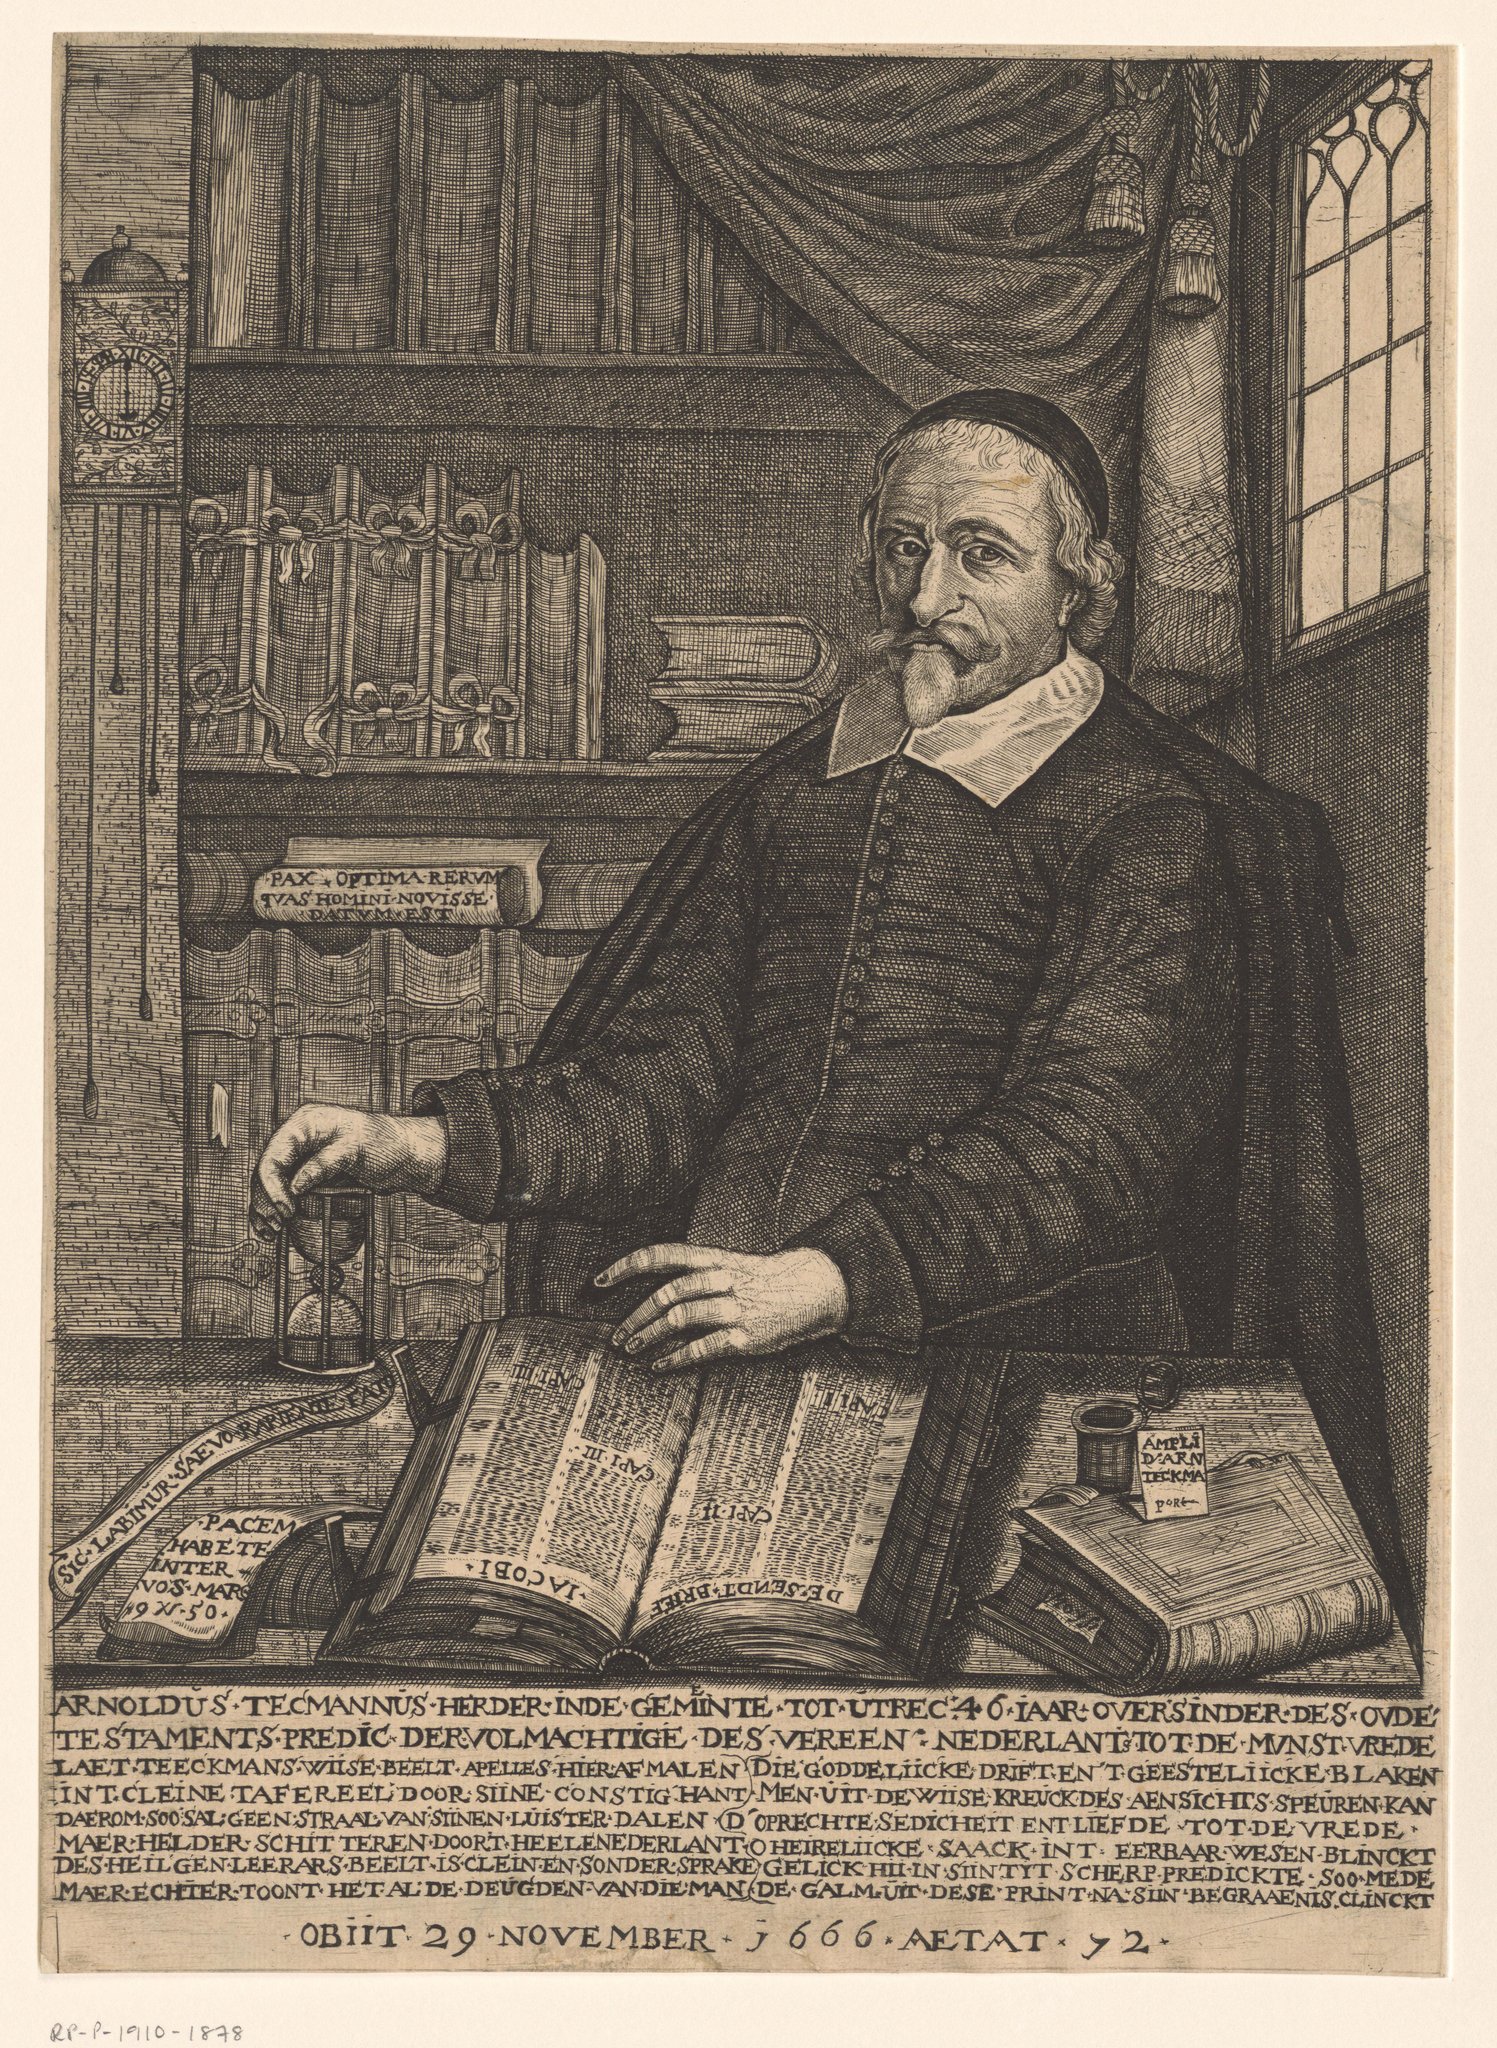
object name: print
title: Portret van Arnoldus Teeckmannus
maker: Anonymous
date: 1666-1699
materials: paper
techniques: engraving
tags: arnoldus teeckmannus, bookshelves, historical persons, functionaries and dignitaries ~ episcopal protestant churches, book, hourglass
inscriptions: collector's mark: Lugt 2228